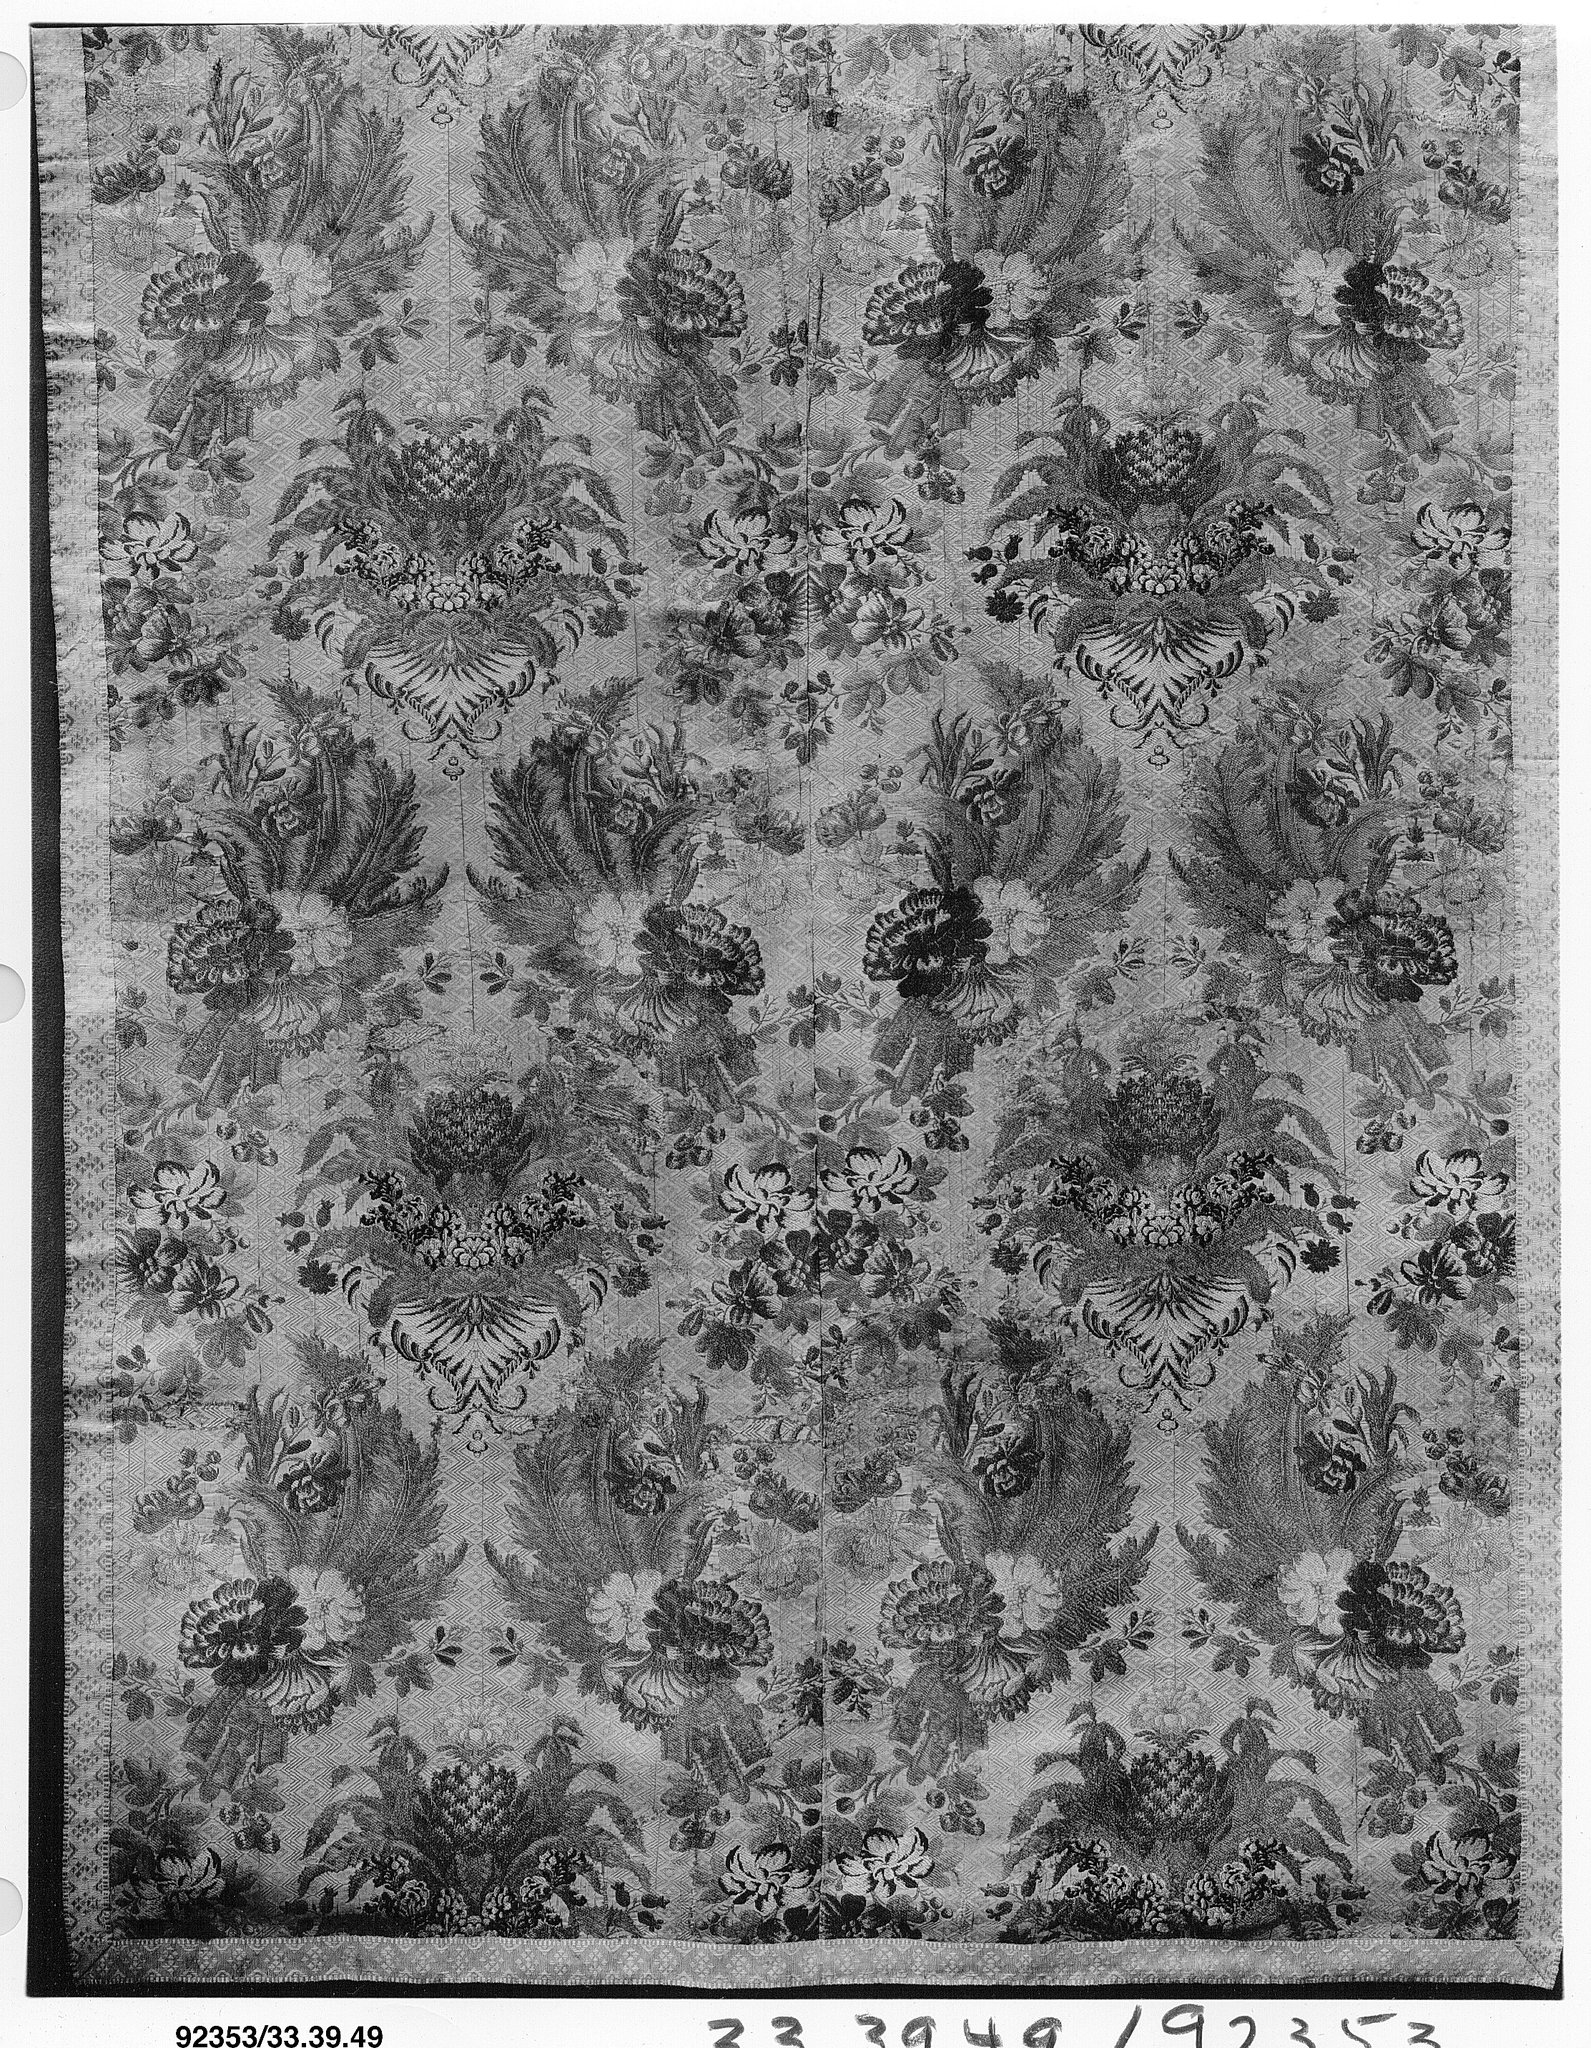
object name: fragment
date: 1730-1735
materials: silk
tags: flowers,leaves